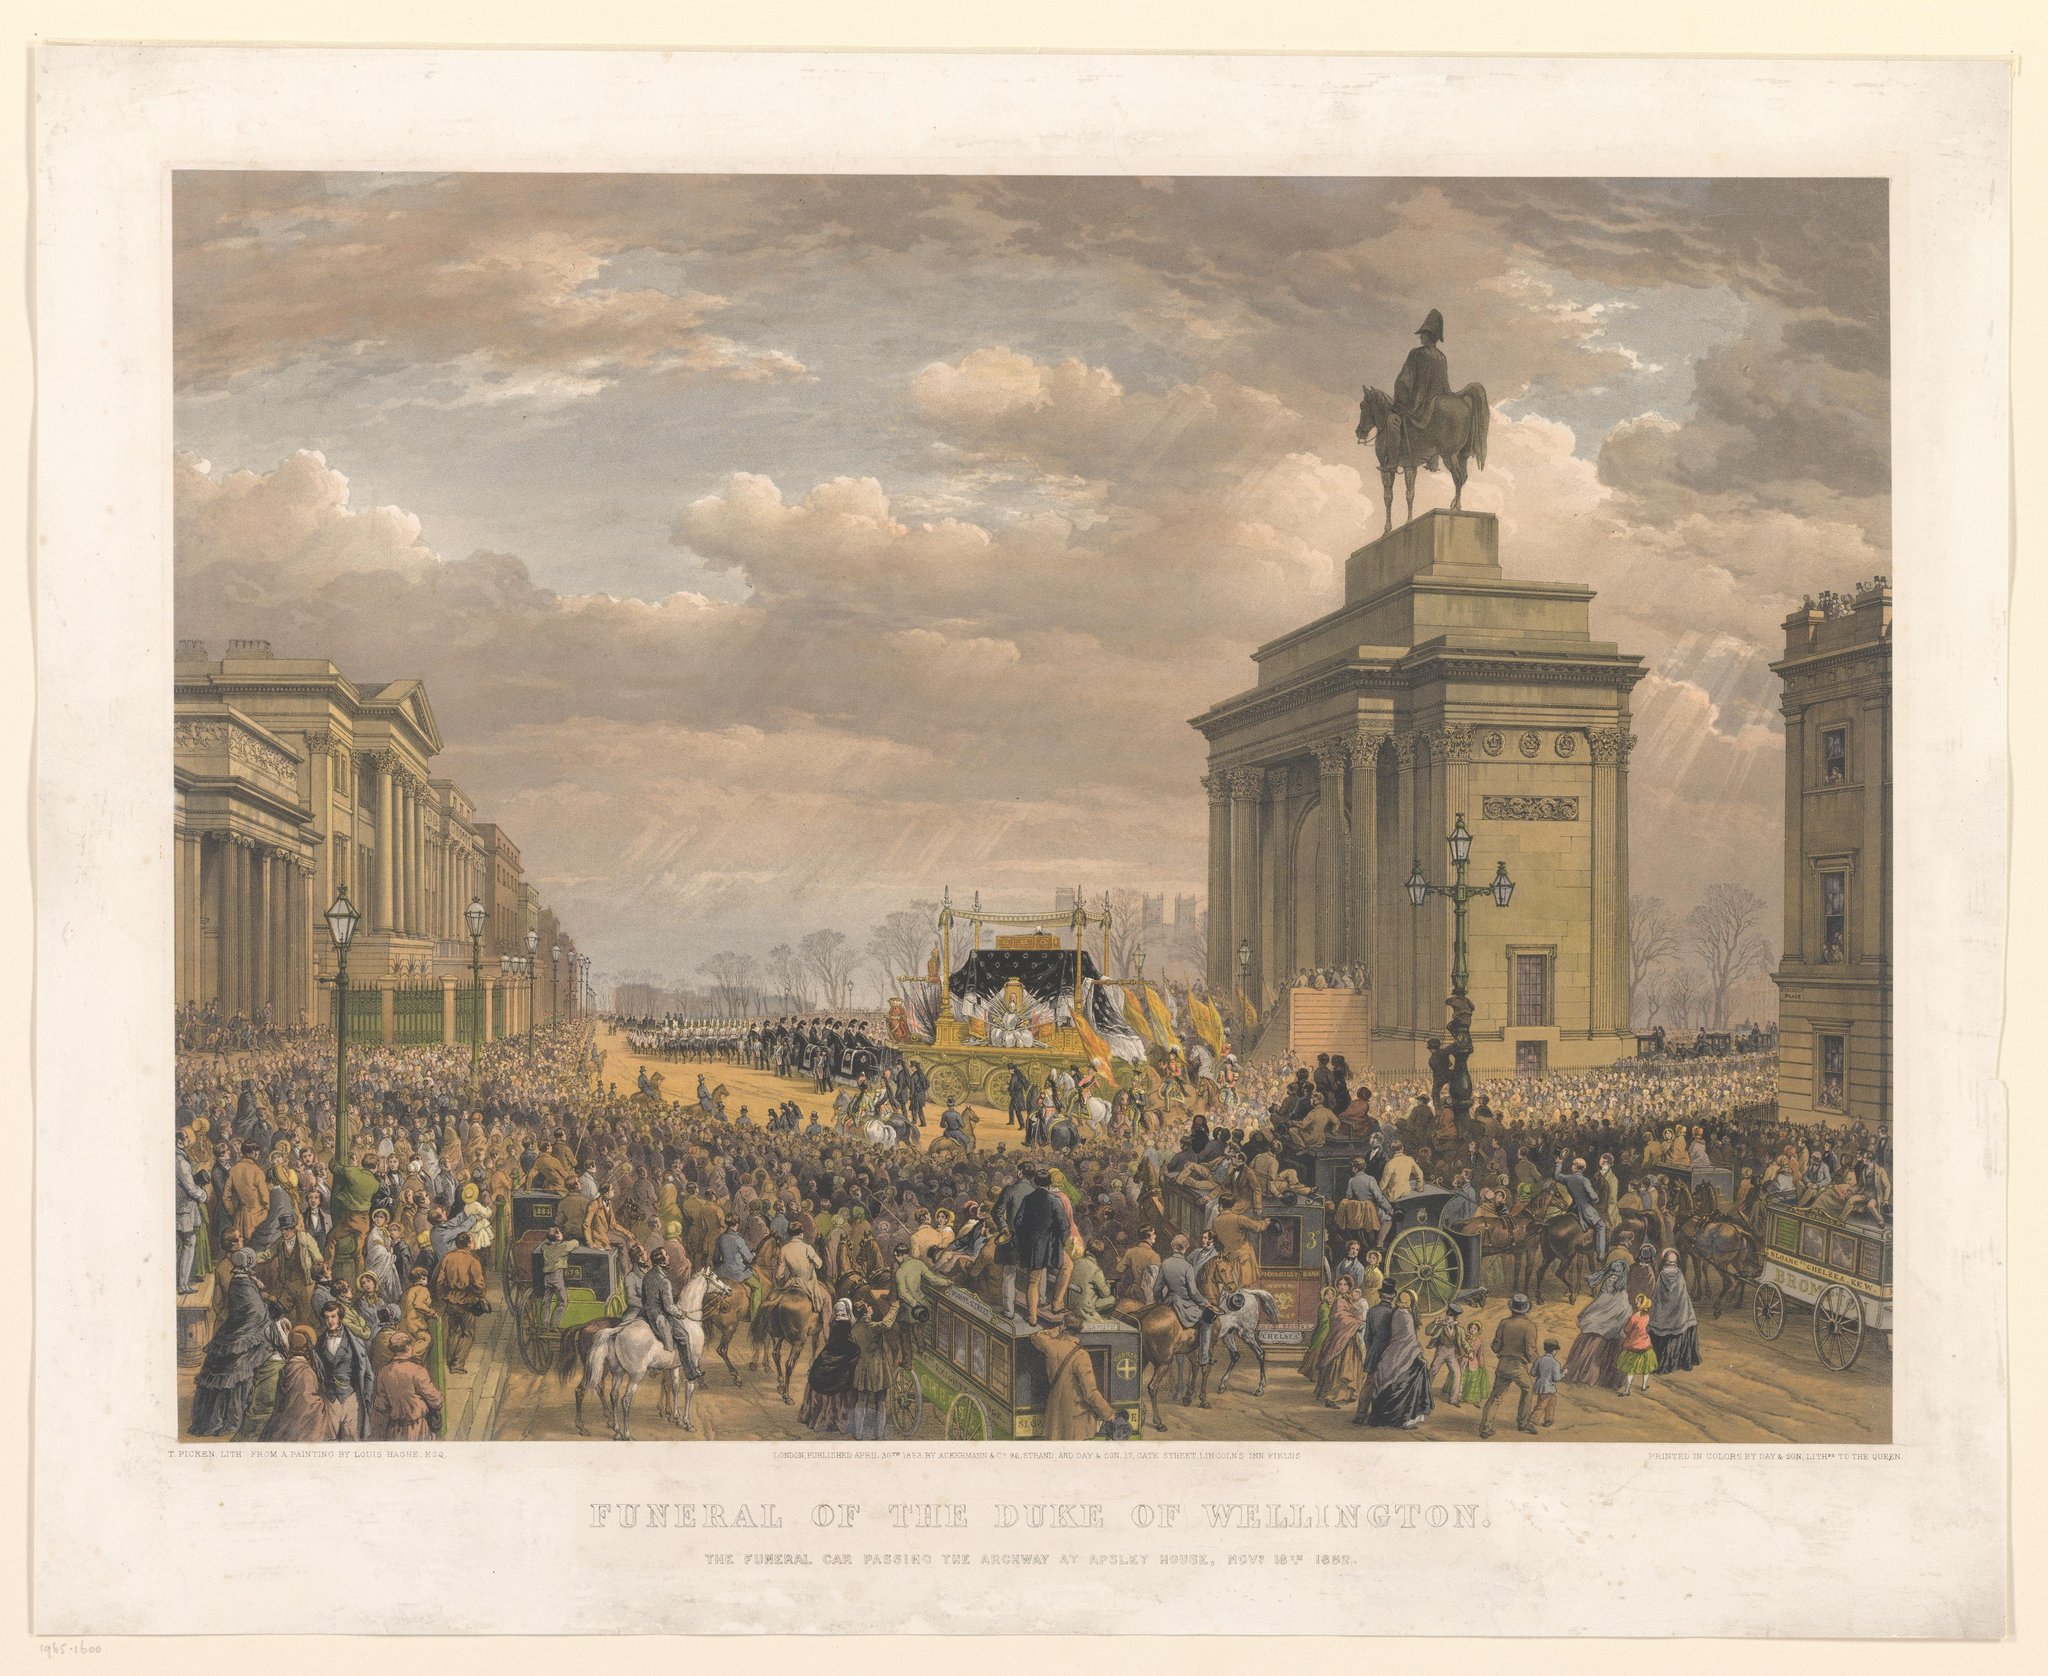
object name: print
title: Begrafenisstoet van de hertog van Wellington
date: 1853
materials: paper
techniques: lithograph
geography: london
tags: funerary ceremonial, monumental adornments (in city), street (+ city(-scape) with figures, staffage), london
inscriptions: collector's mark: Lugt 2228